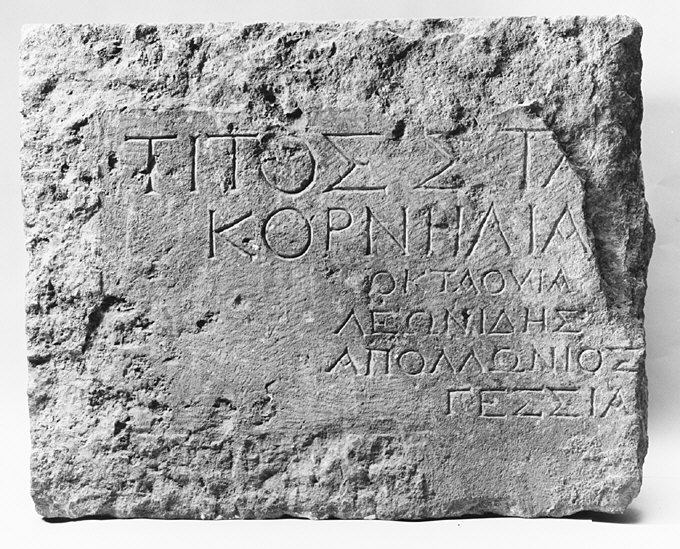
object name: architrave with inscription, fragment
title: Marble architrave with inscription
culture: roman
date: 1-100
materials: marble